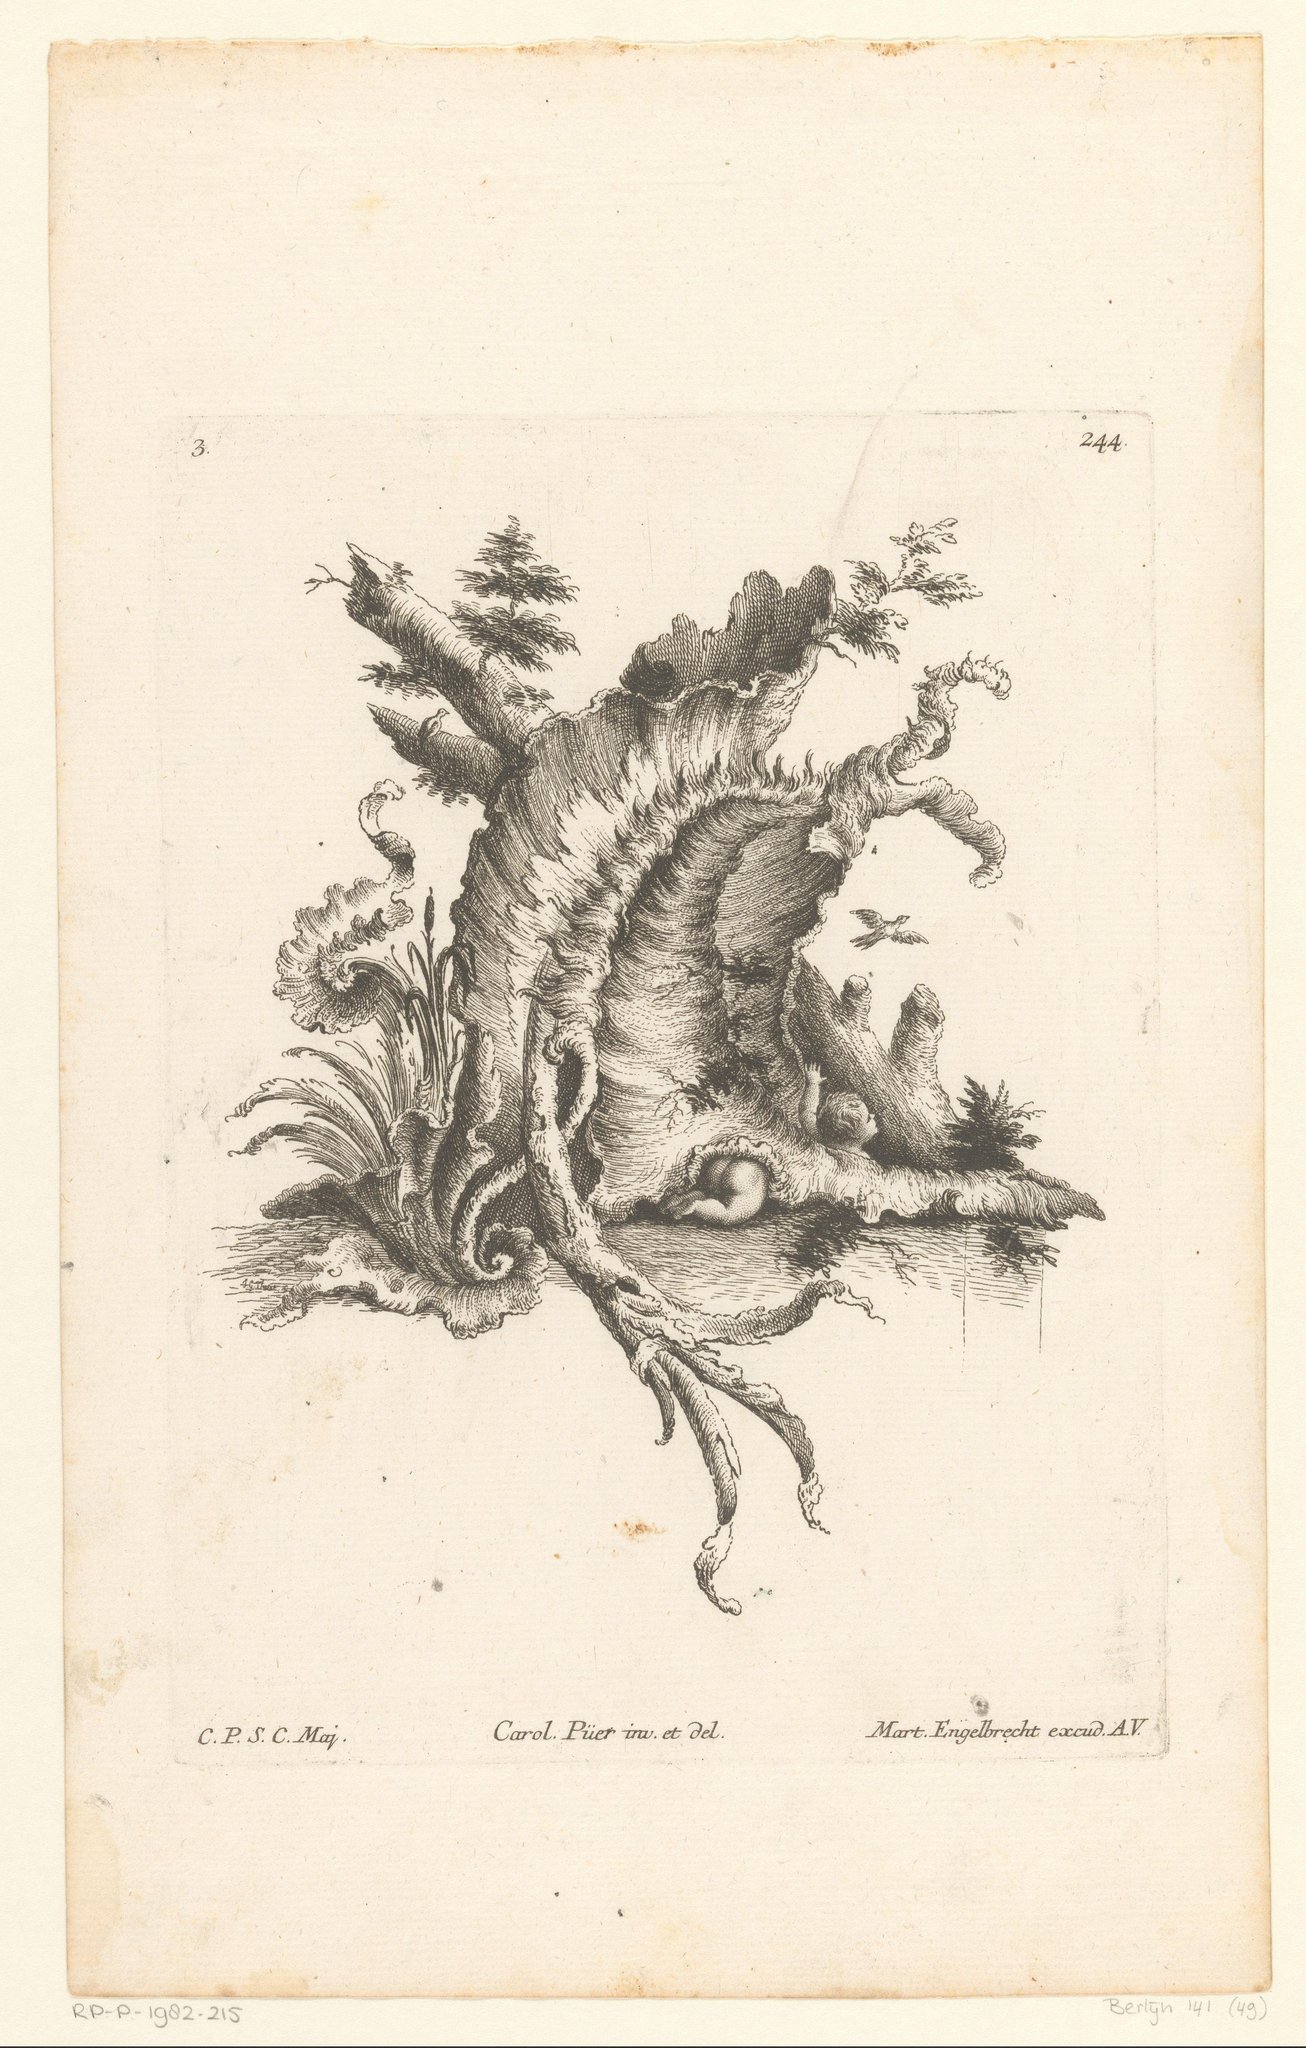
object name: print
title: Cartouche met putto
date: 1745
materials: paper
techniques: etching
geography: augsburg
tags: ornament ~ cartouche, cupids: 'amores', 'amoretti', 'putti'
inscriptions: collector's mark: Lugt 2228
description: Een putto kruipt onder een rocaille cartouche in een landschap. Prentnummer 244.